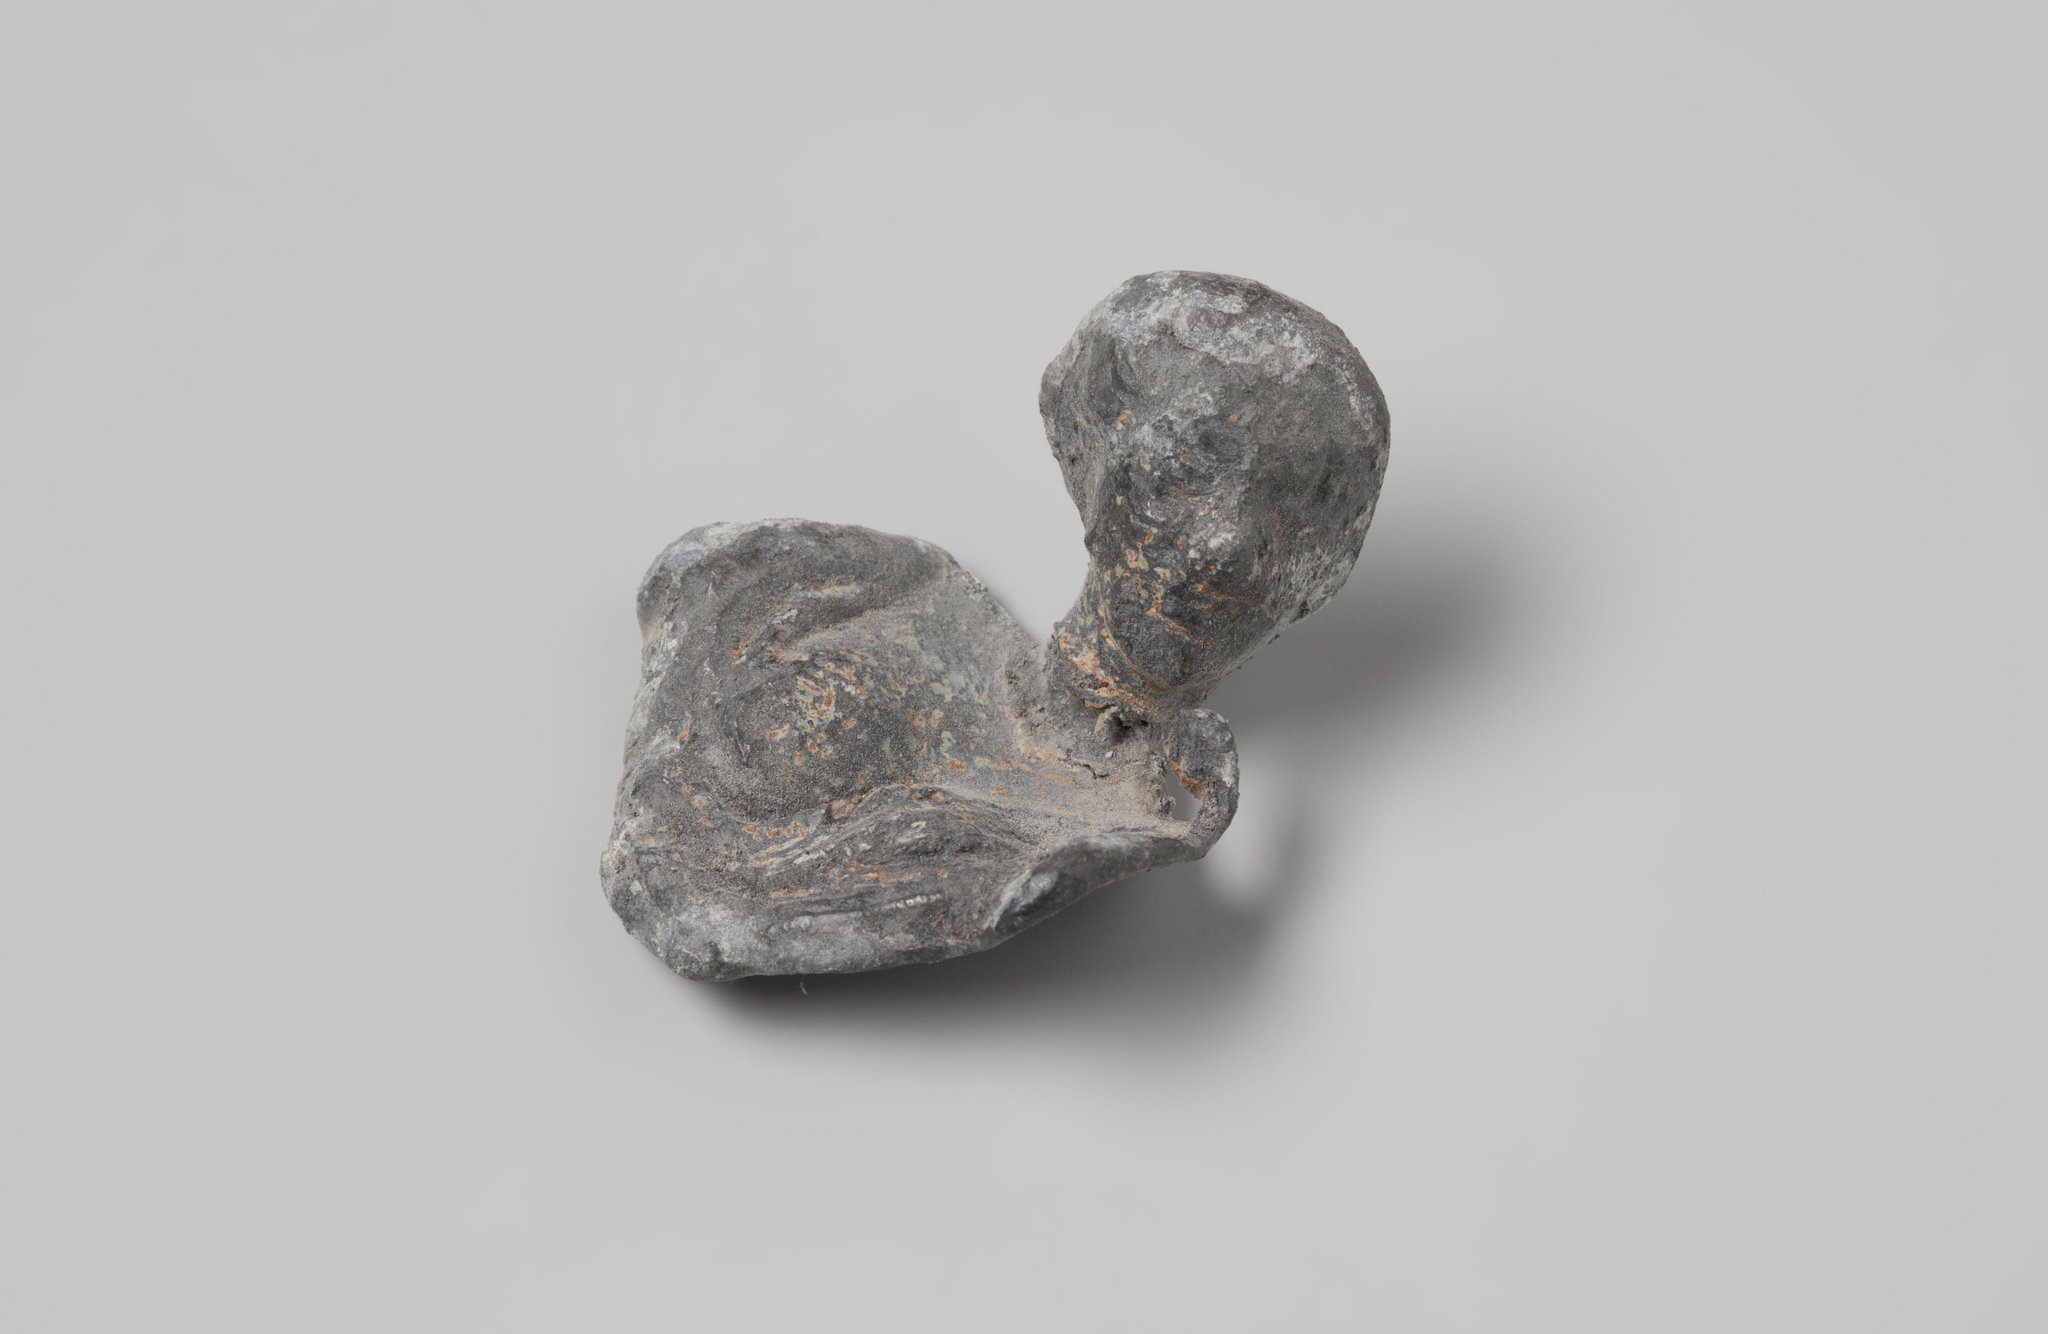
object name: beslag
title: Decoratief beslag uit het wrak van de Oost-Indiëvaarder Hollandia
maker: Anonymous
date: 1700-1743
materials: lead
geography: netherlands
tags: verenigde oostindische compagnie, hollandia (schip), annet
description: Fitting, decorative fitting or fragment; fragm, id. NG 1980-27H1051, squashed, eroded. Buste with head.